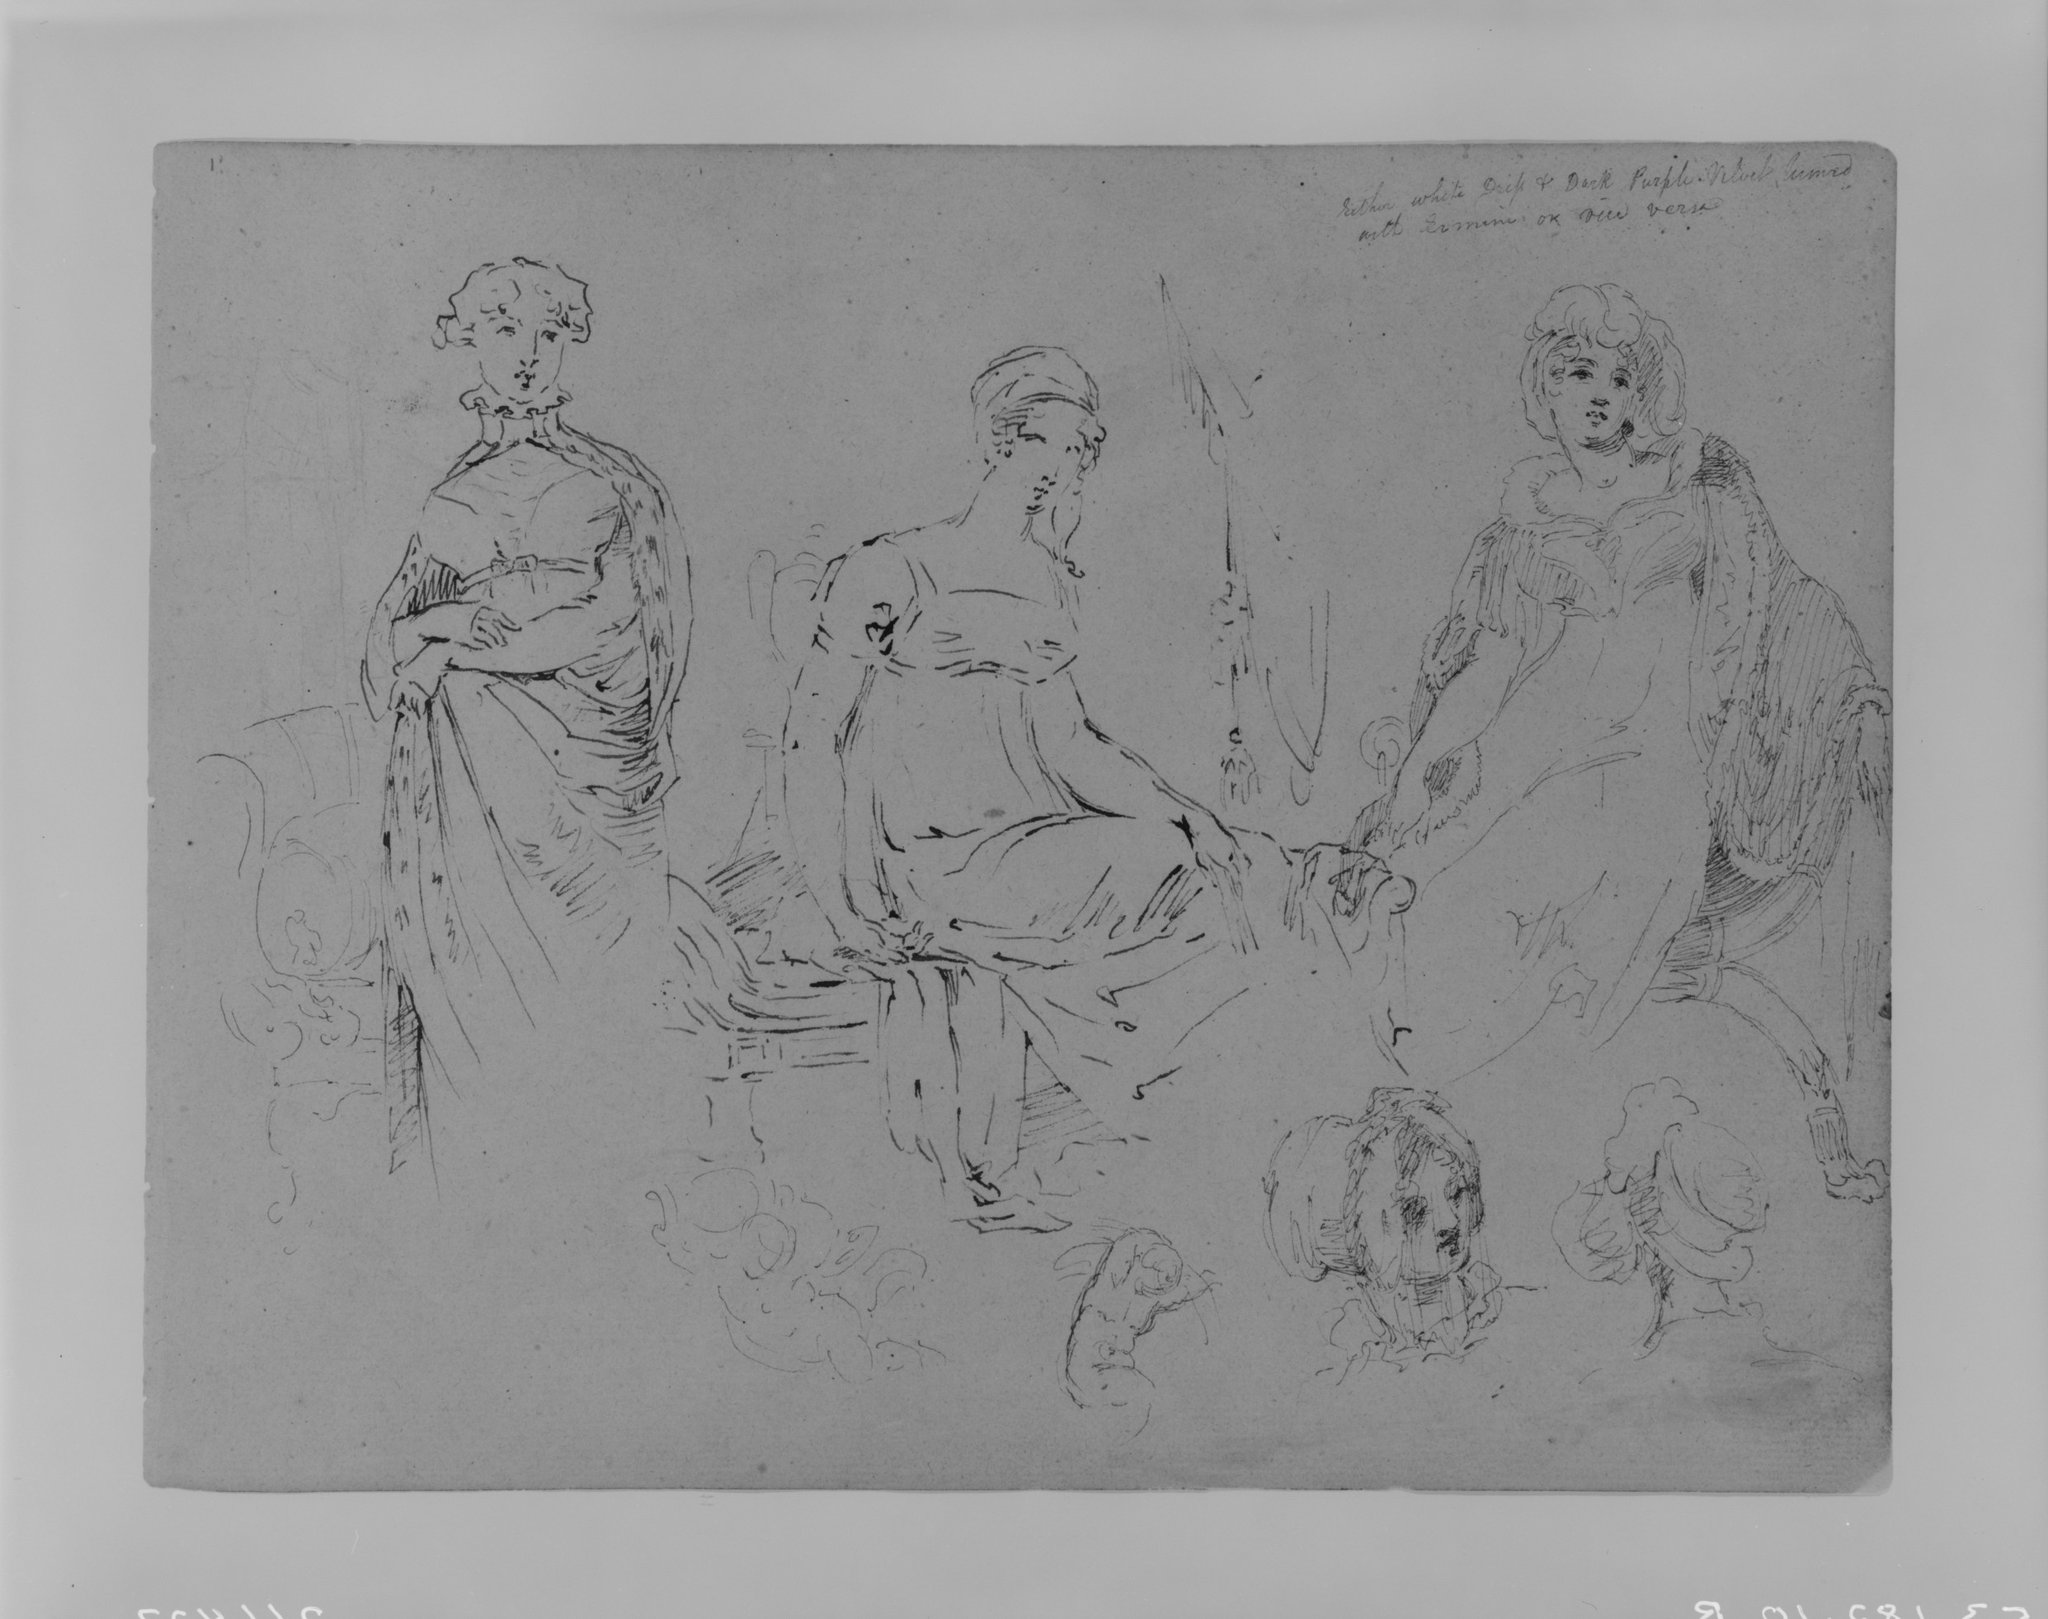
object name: drawing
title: One Standing Woman; Two Seated Women in Fashionable Attire, All 3/4 Length; Two Female Heads in Bonnets (from Sketchbook)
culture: american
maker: thomas sully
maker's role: artist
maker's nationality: american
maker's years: 1783-1872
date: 1810-1820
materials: ink, paper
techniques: wash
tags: women